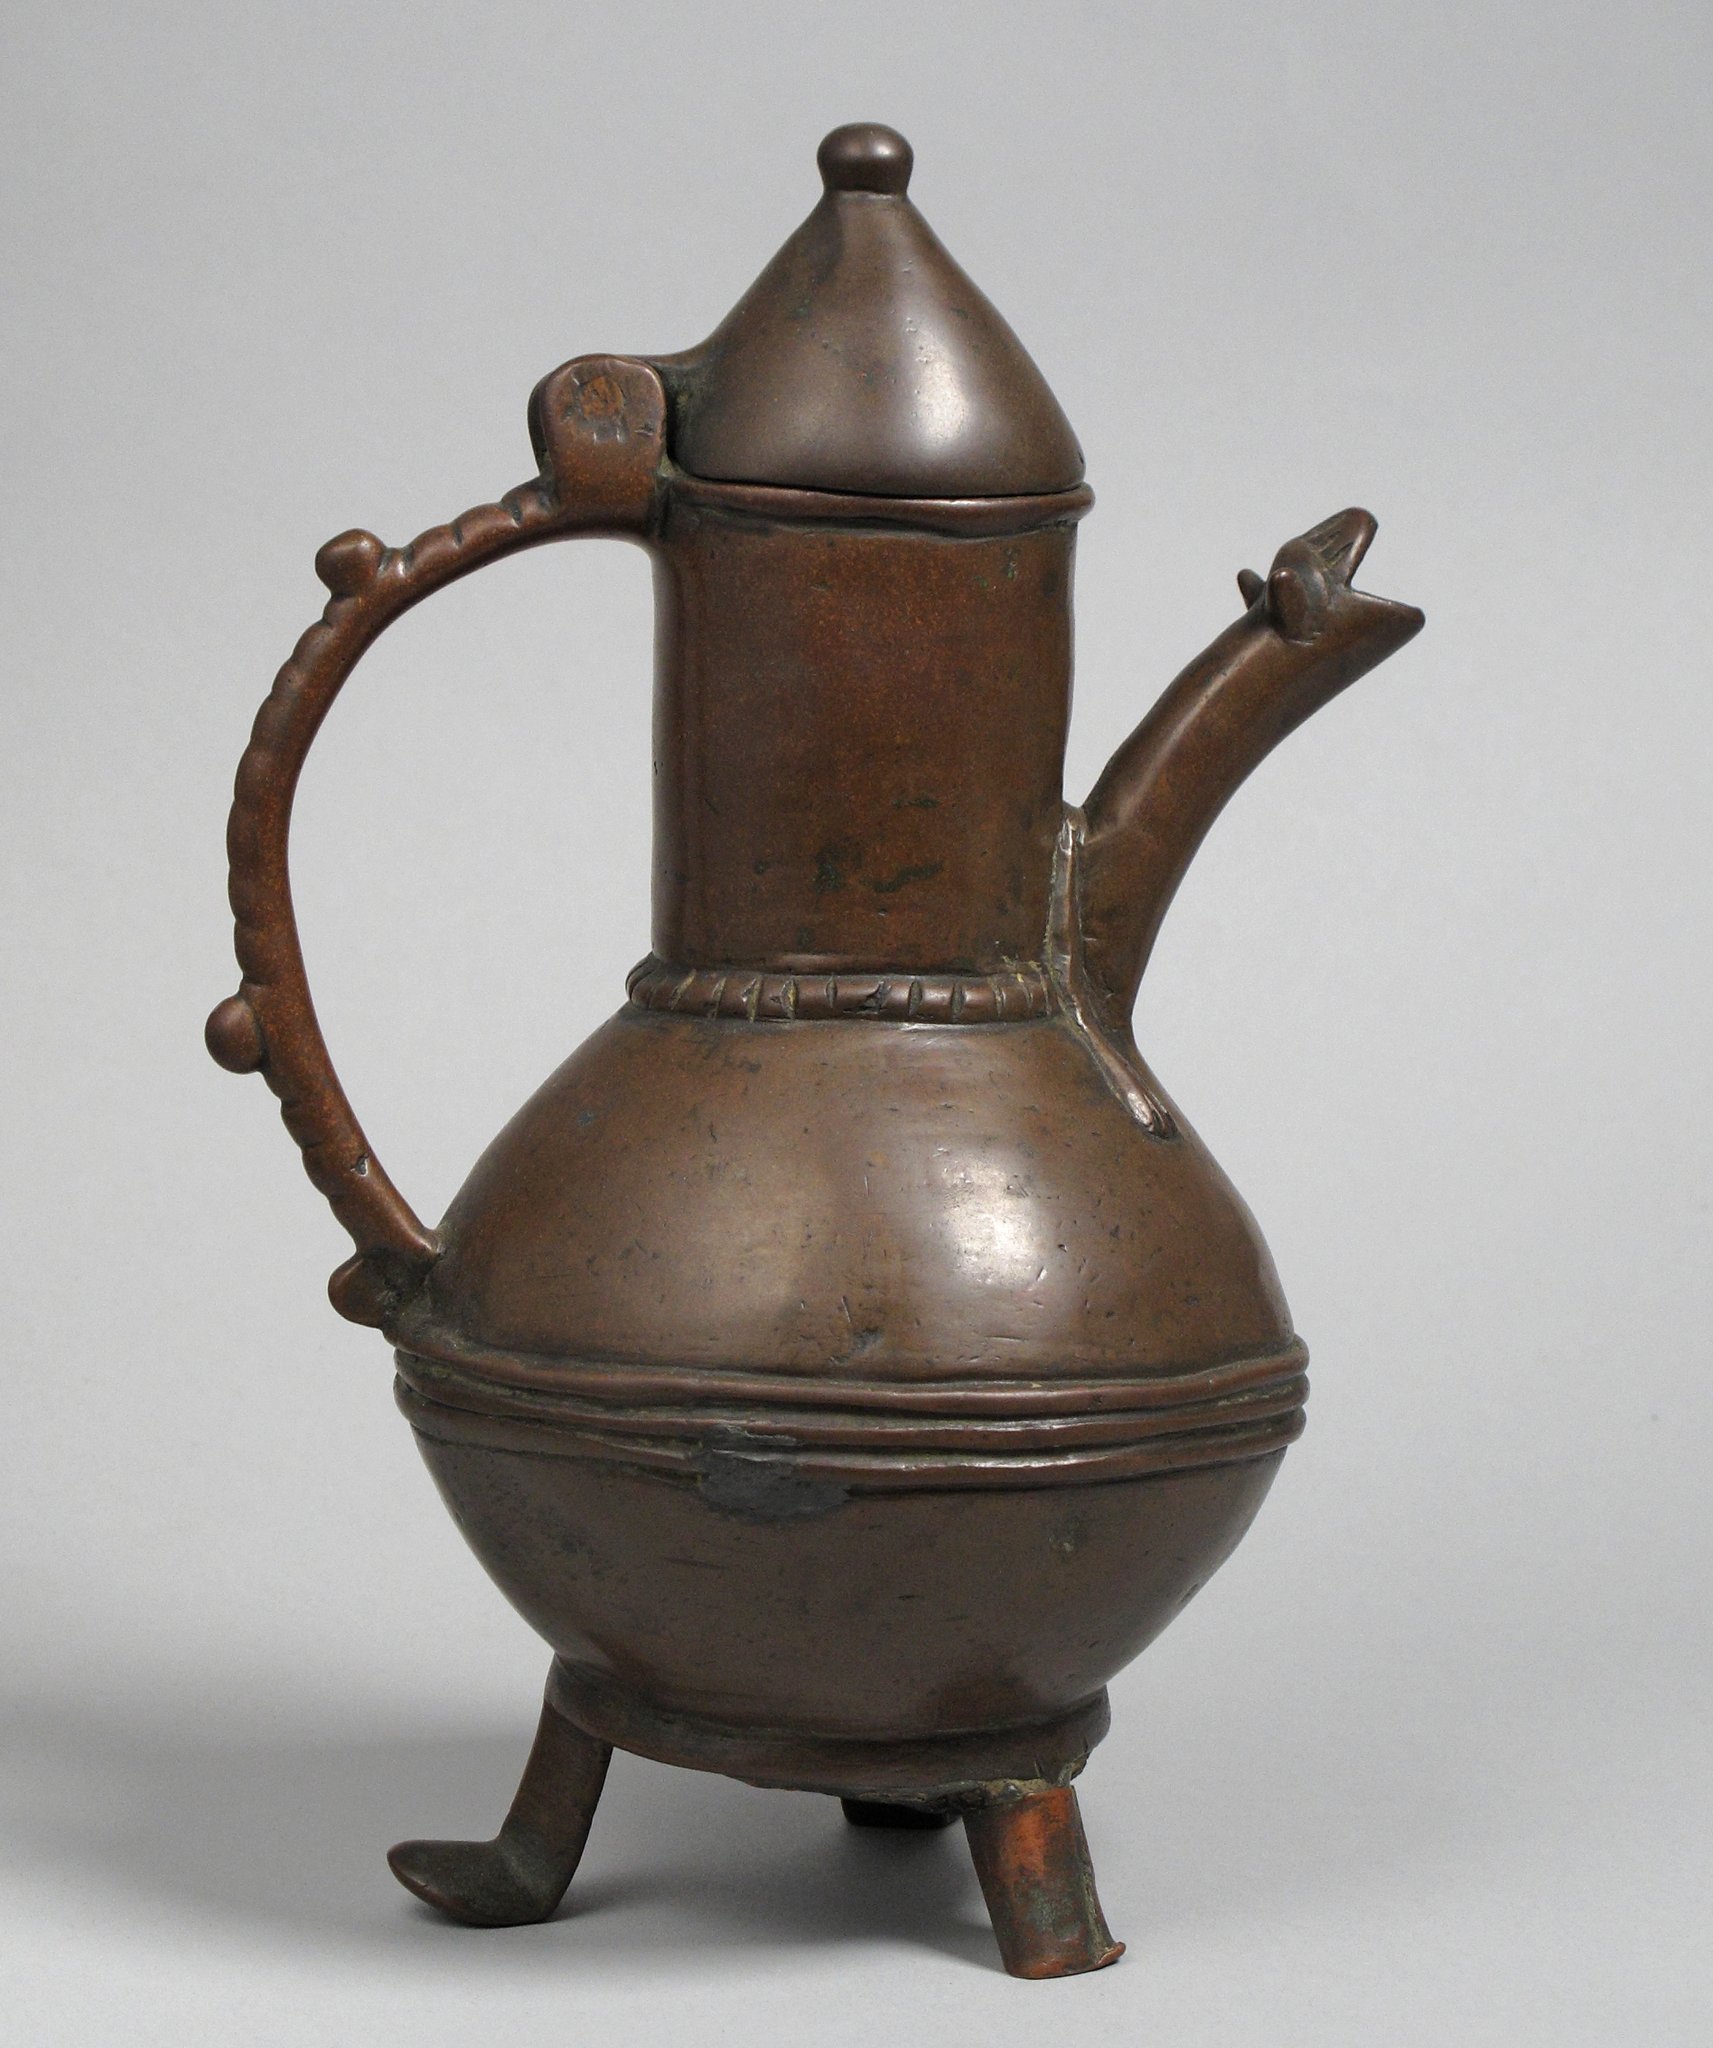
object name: ewer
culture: european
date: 1101-1200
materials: bronze, gilt